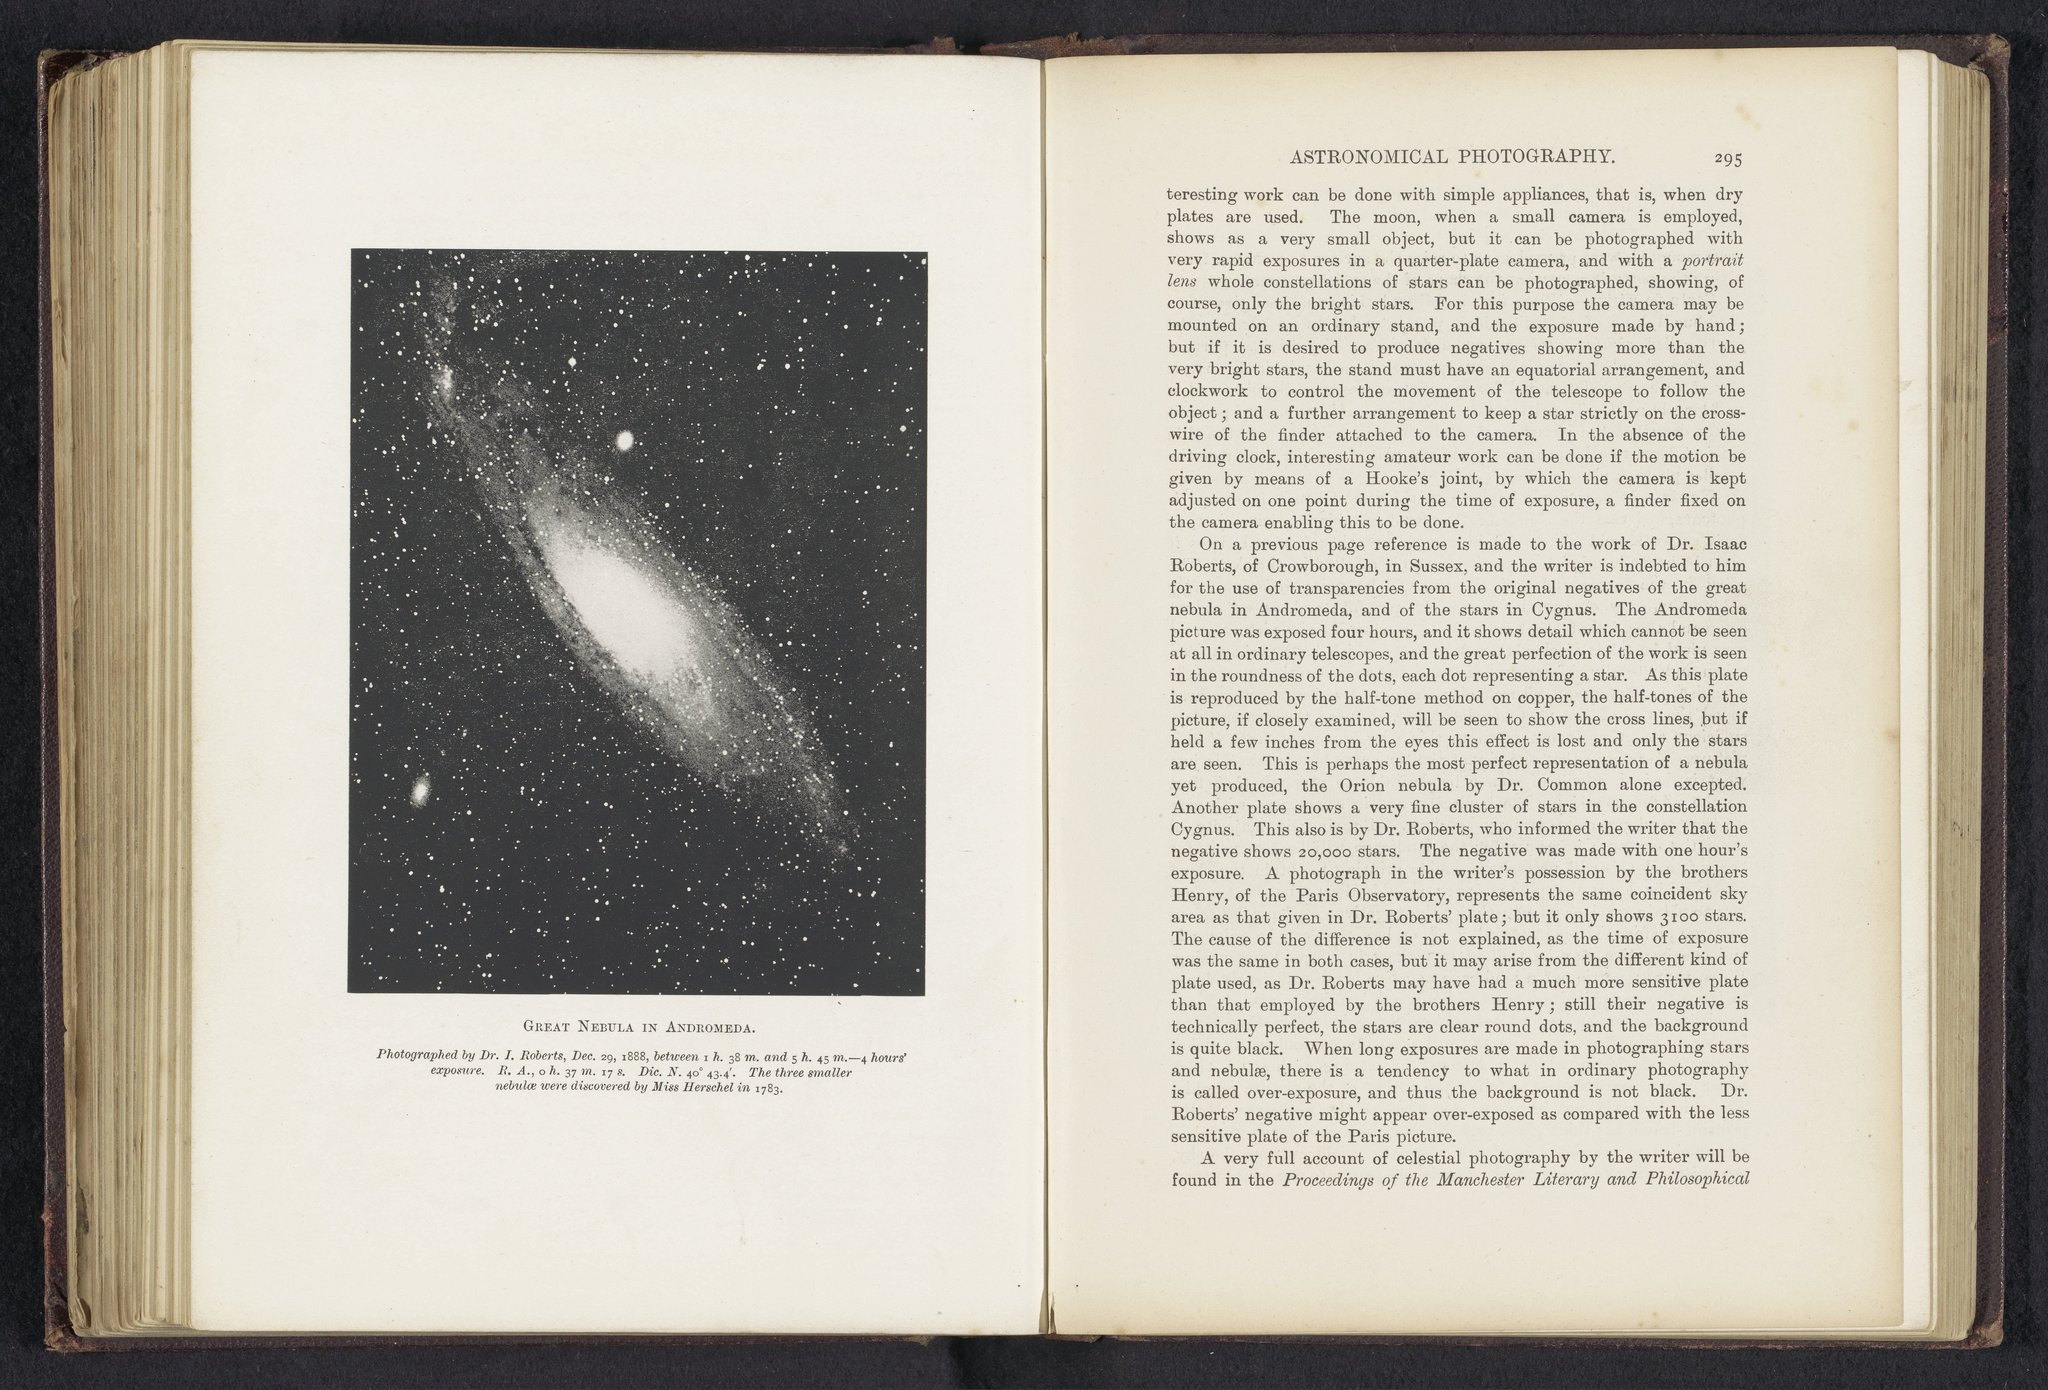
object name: photomechanical print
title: Great nebula in Andromeda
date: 1888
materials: paper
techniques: autotype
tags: astronomical phenomena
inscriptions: inscription: ‘Photographed by (...) Miss Herschel in 1783.’